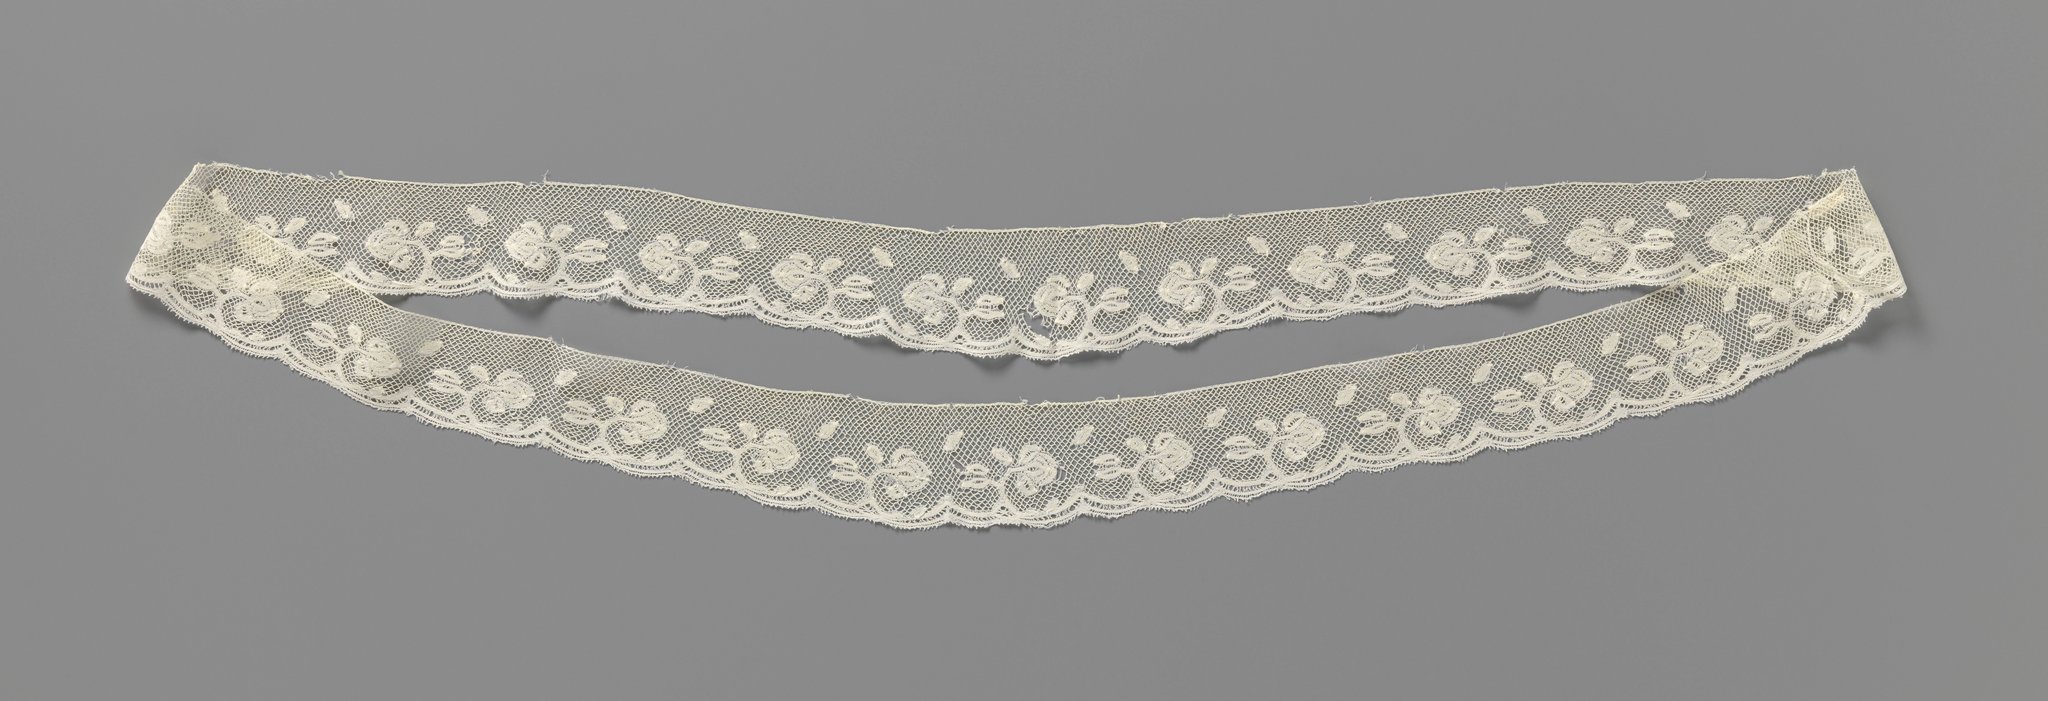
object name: strip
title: Strook kloskant met bloem en bloemknop aan gebogen tak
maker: Anonymous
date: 1880-1910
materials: linen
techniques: lace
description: Strook naturelkleurige kloskant: Valenciennes-kant. Het zich herhalende patroon bestaat uit een gebogen tak met daaraan een bloem en een bloemknop. De tak ontspringt uit de flauw geschulpte rand langs de onderkant van de strook. Schuin boven elke tak een los blad met spitsovale vorm. De motieven zijn gemaakt in linnenslag met opengewerkte randjes en zijn met elkaar verbonden door een vierkante Valenciennes-grond. De bovenzijde is afgewerkt met een rechte rand. De korte kanten van de strook zijn aan elkaar genaaid.